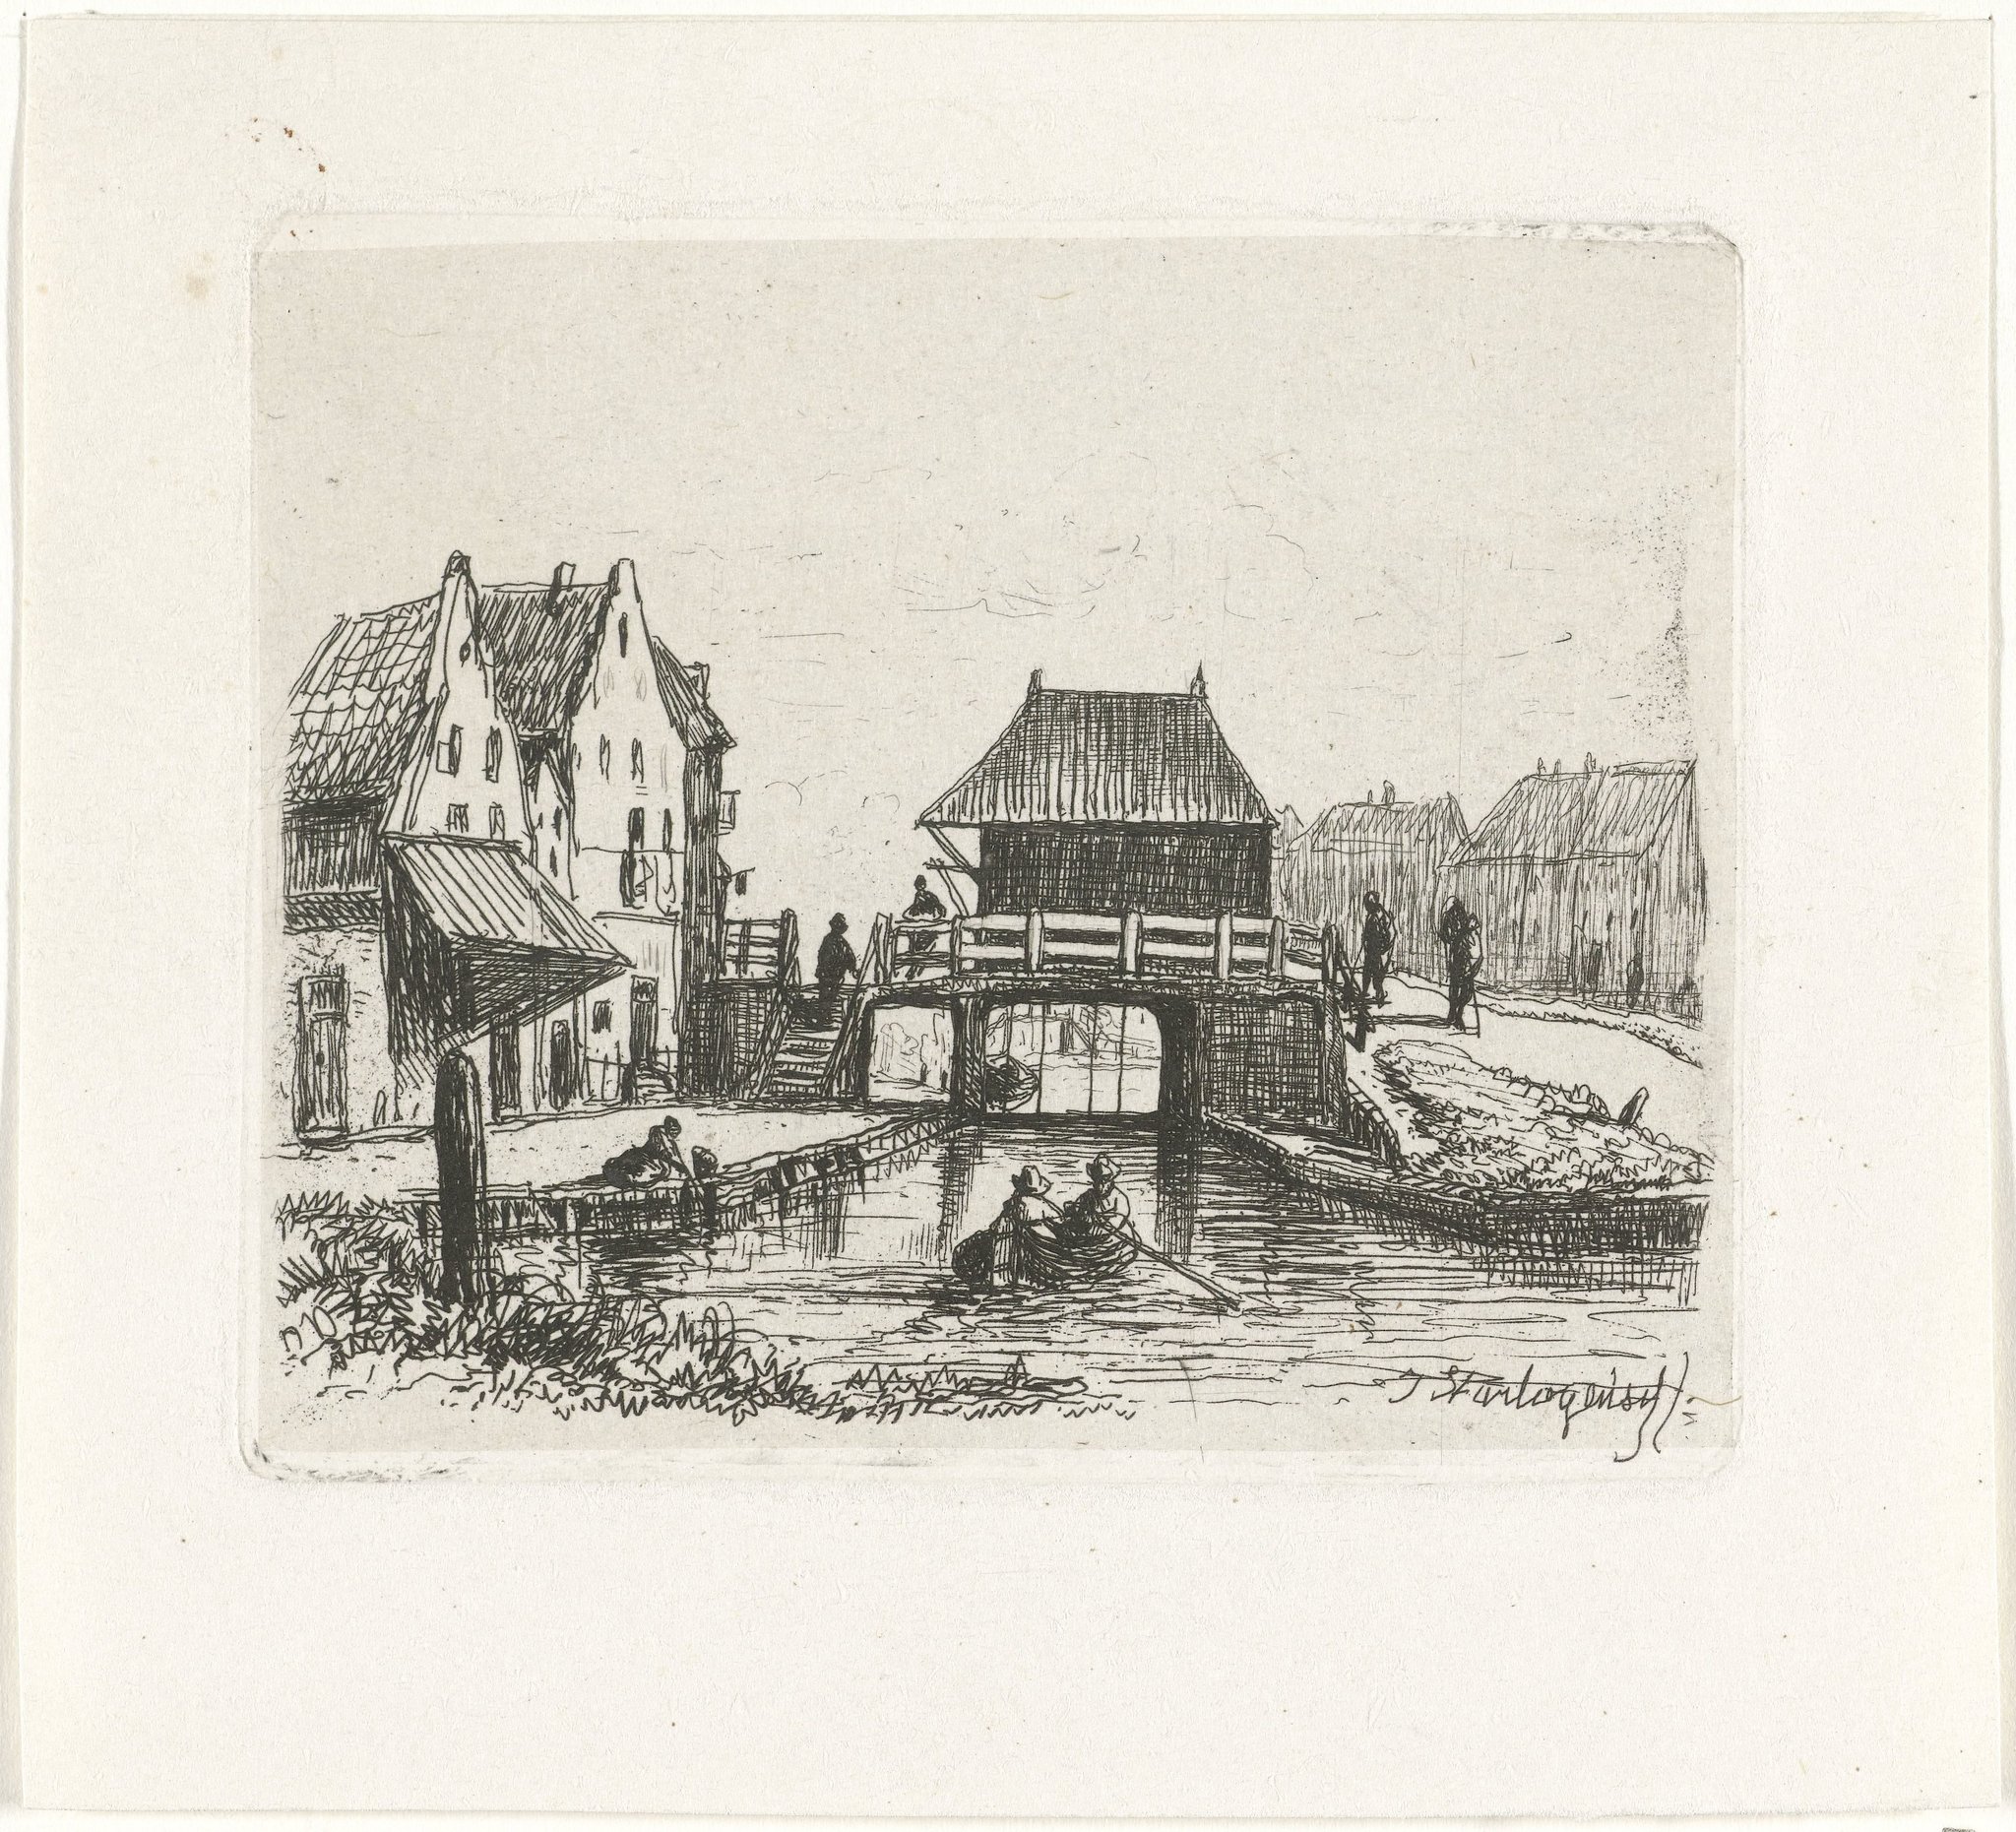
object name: print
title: Gezicht op een brug over een gracht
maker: joseph hartogensis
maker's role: painter, print maker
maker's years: 1822-1865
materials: paper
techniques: etching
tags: bridge in village across river, canal, etc. (+ city(-scape) with figures, staffage)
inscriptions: collector's mark: Lugt 2228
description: De titel 'Leidschendam' afkomstig van eerdere staat.